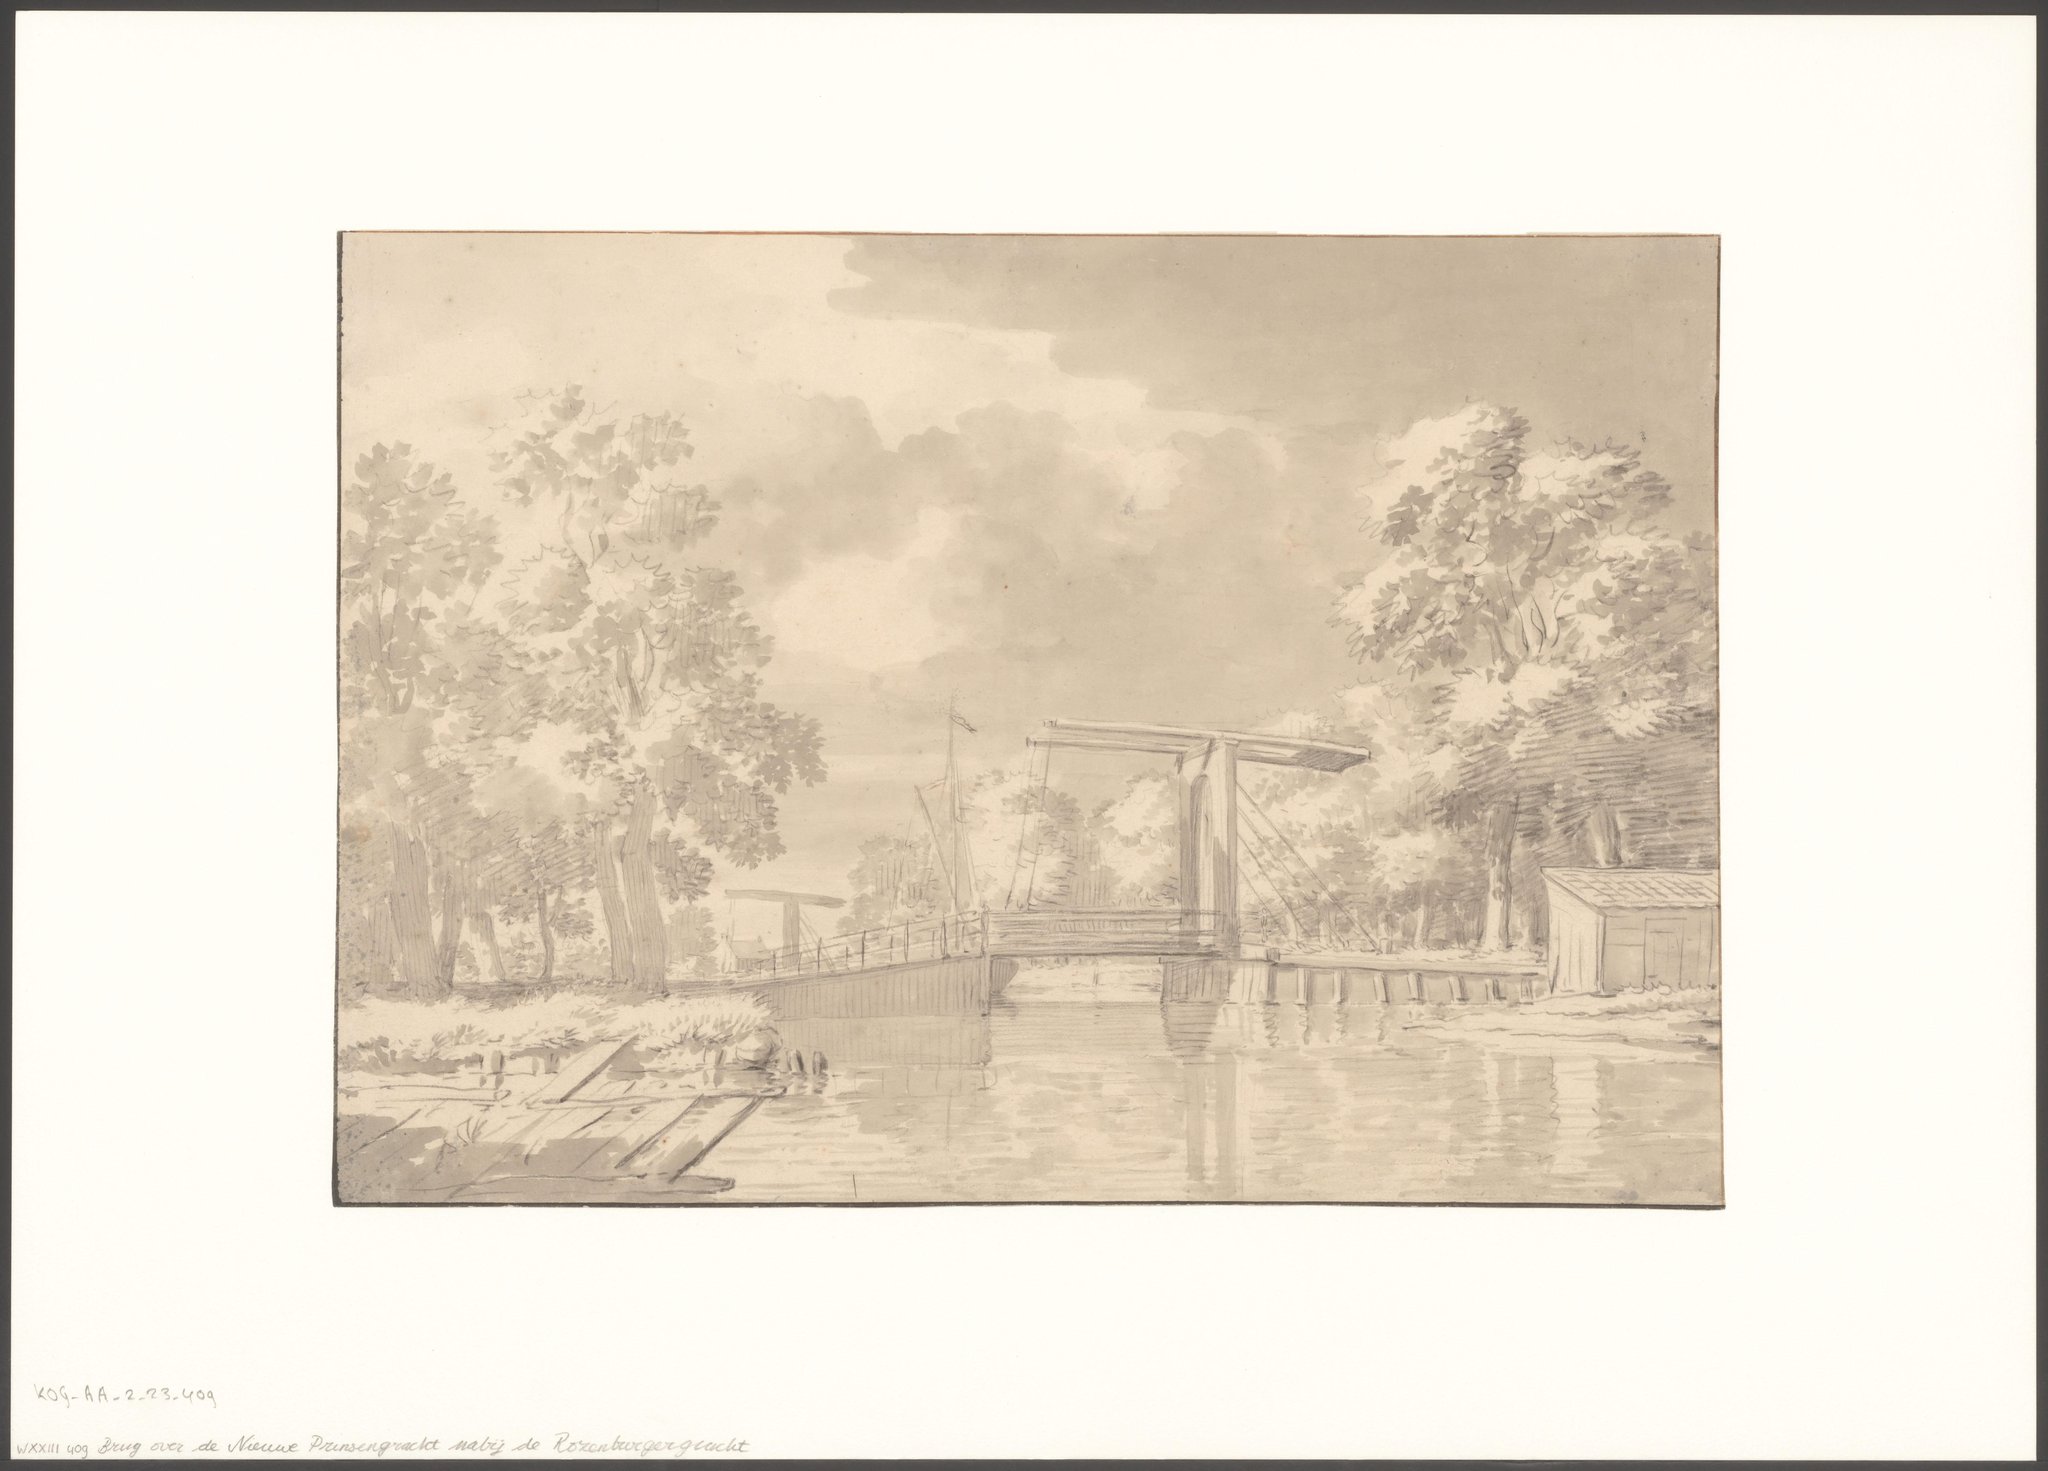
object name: drawing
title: Gezicht op de Nieuwe Prinsengracht, gezien naar de Rapenburgergracht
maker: jacob cats (1741-1799)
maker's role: draughtsman, print maker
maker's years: 1741-1799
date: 1751-1799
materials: chalk, ink, paper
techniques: brush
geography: amsterdam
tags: city-view in general; 'veduta', canal, bridge in city across river, canal, etc.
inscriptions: signature: ‘J. Cats / fec’, collector's mark: Lugt 800a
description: Tekening binnen de Atlas Van Eck ingedeeld op wijknummer 23.